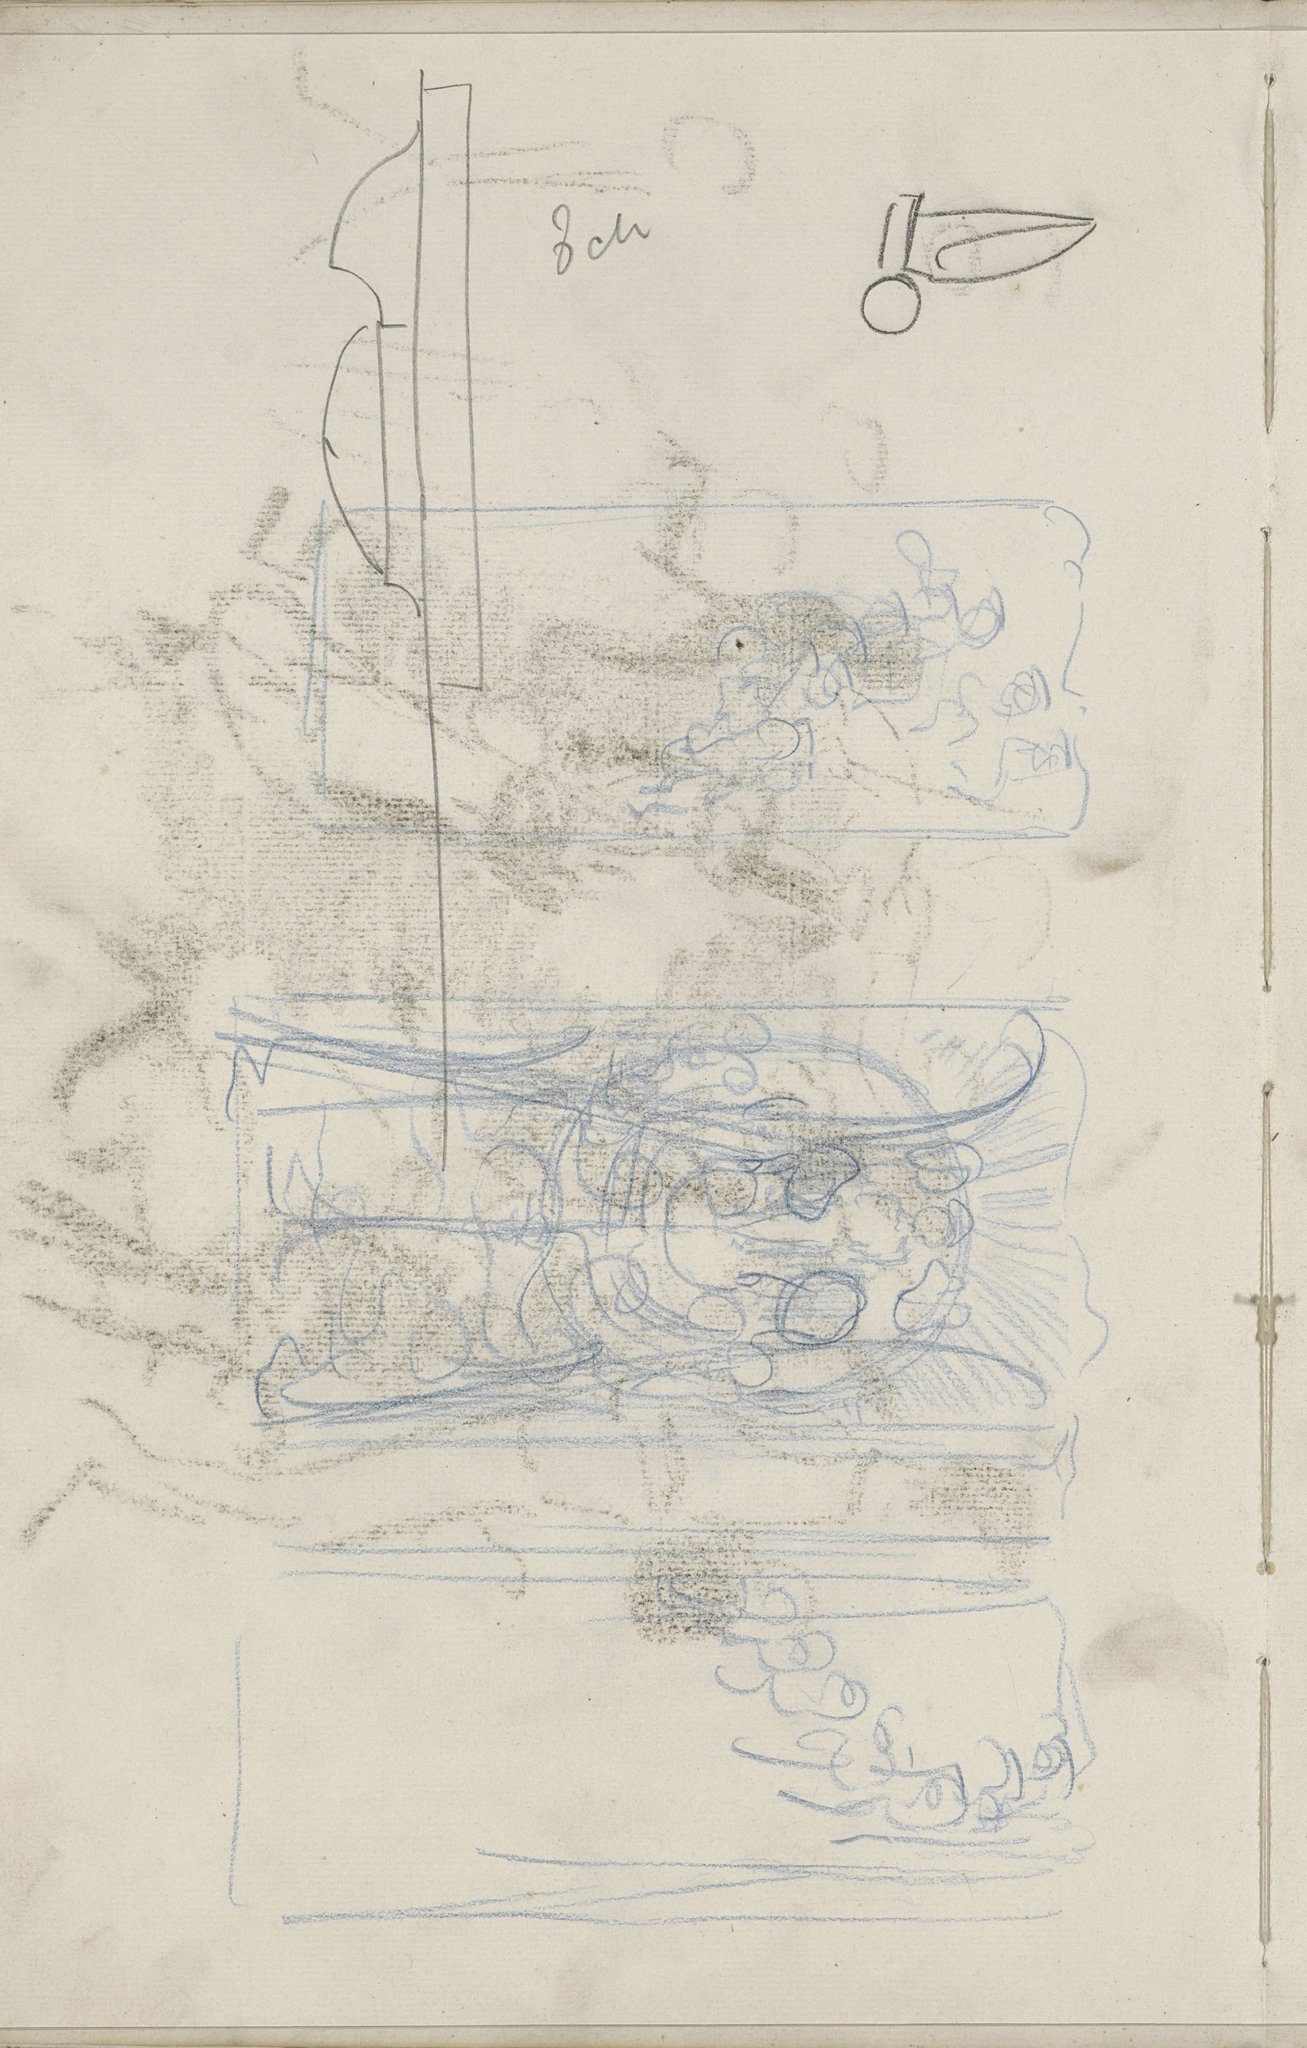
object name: sketchbook leaf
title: Studies, mogelijk ornamentontwerpen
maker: carel adolph lion cachet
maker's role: draughtsman, print maker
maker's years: 1864-1945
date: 1895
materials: chalk, paper, pencil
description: Blad 9 verso uit een schetsboek met 23 bladen.